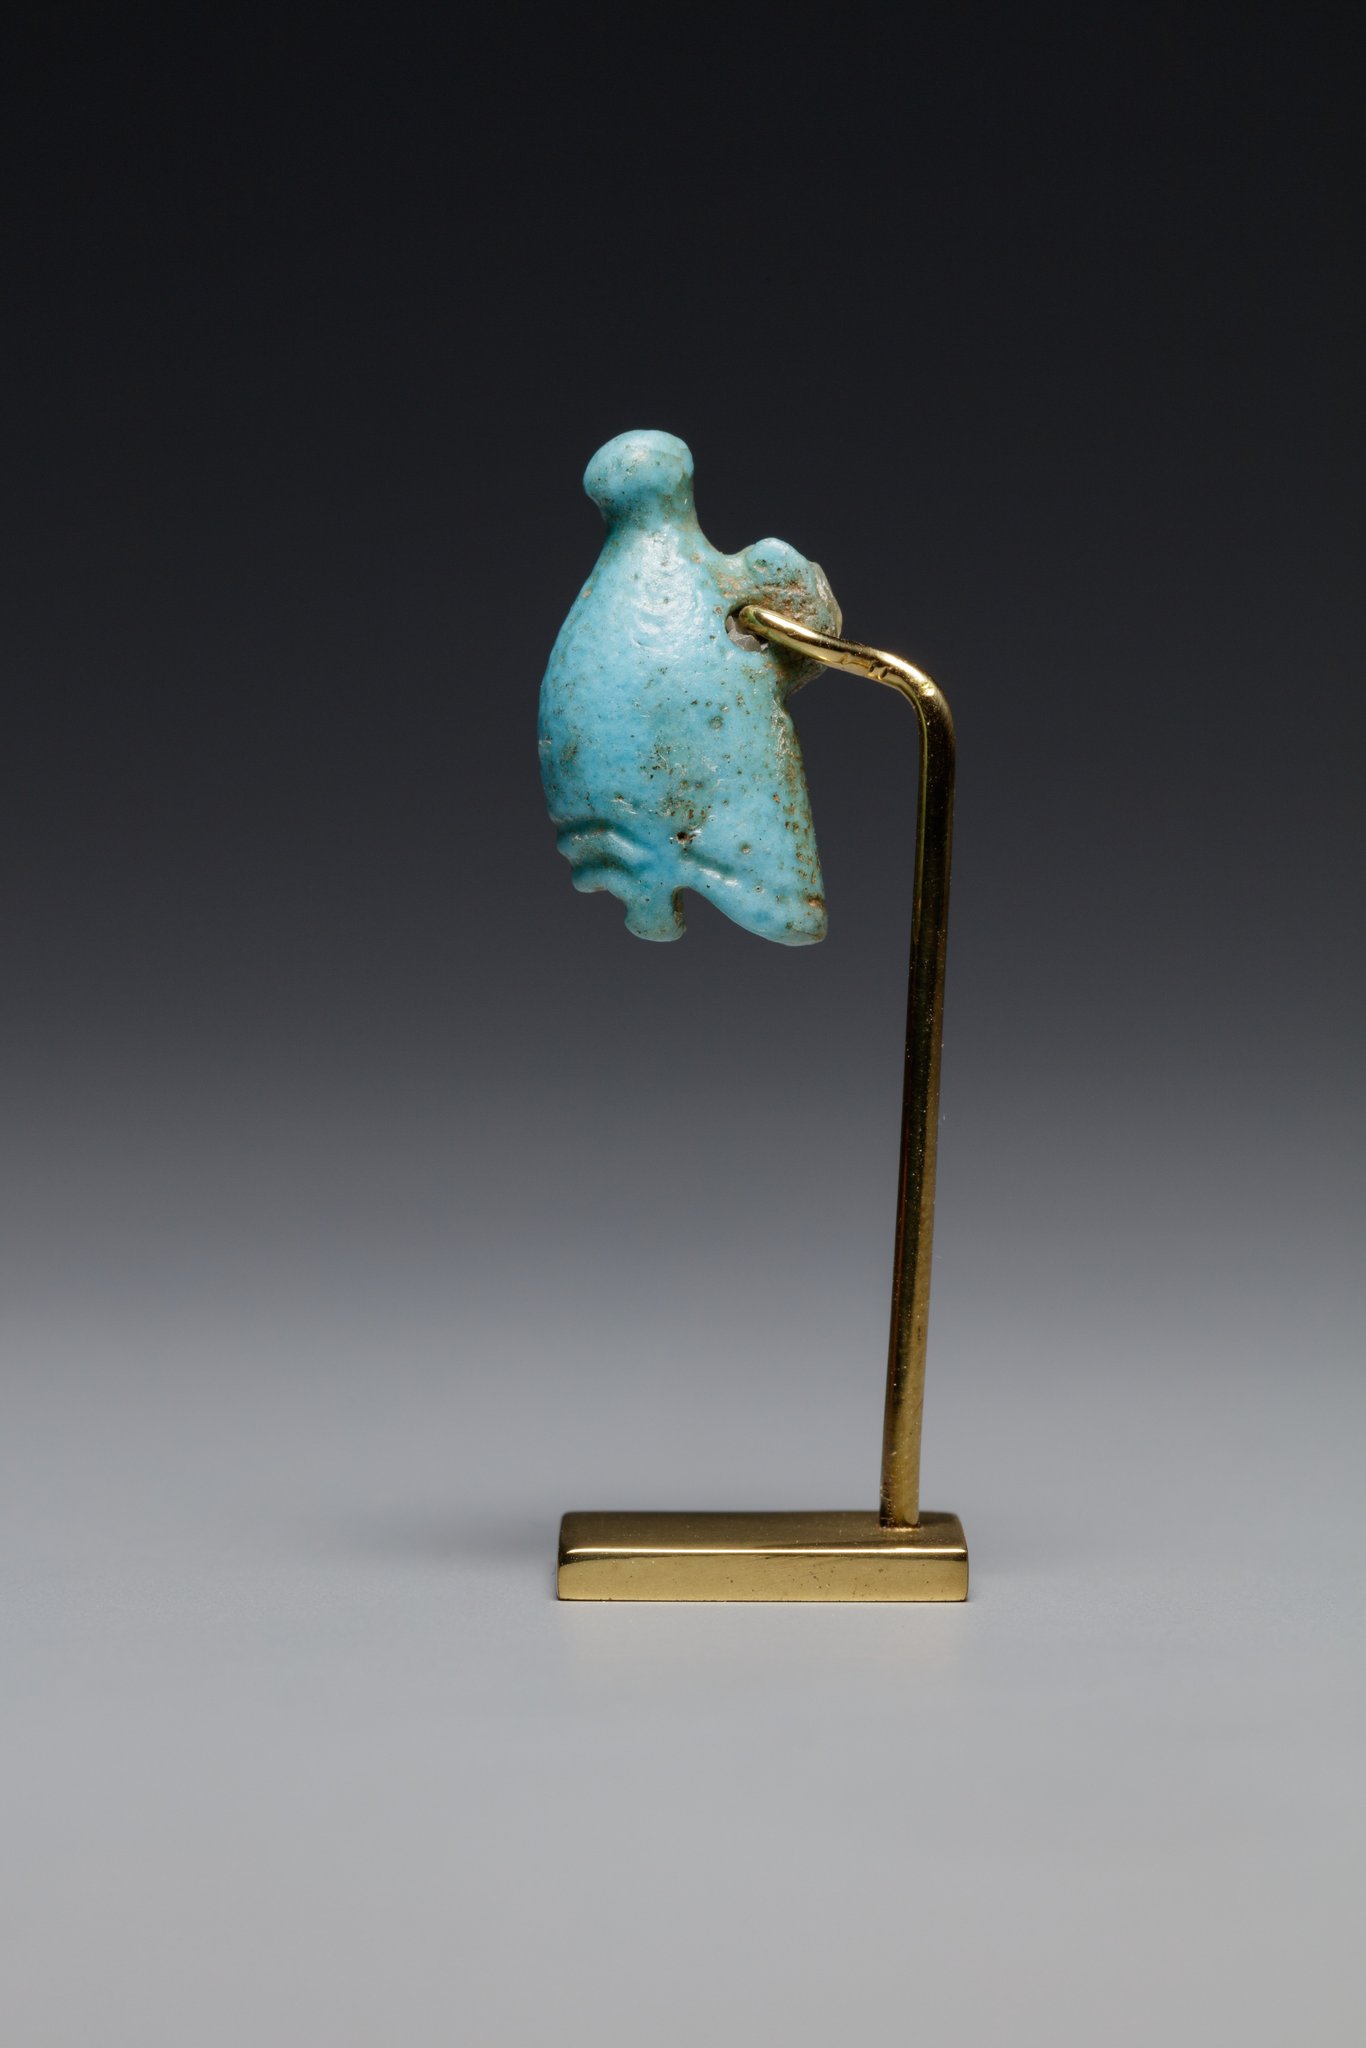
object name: amulet, crown, upper egypt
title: Amulet: Crown of Upper Egypt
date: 664-332 BCE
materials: faience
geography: egypt